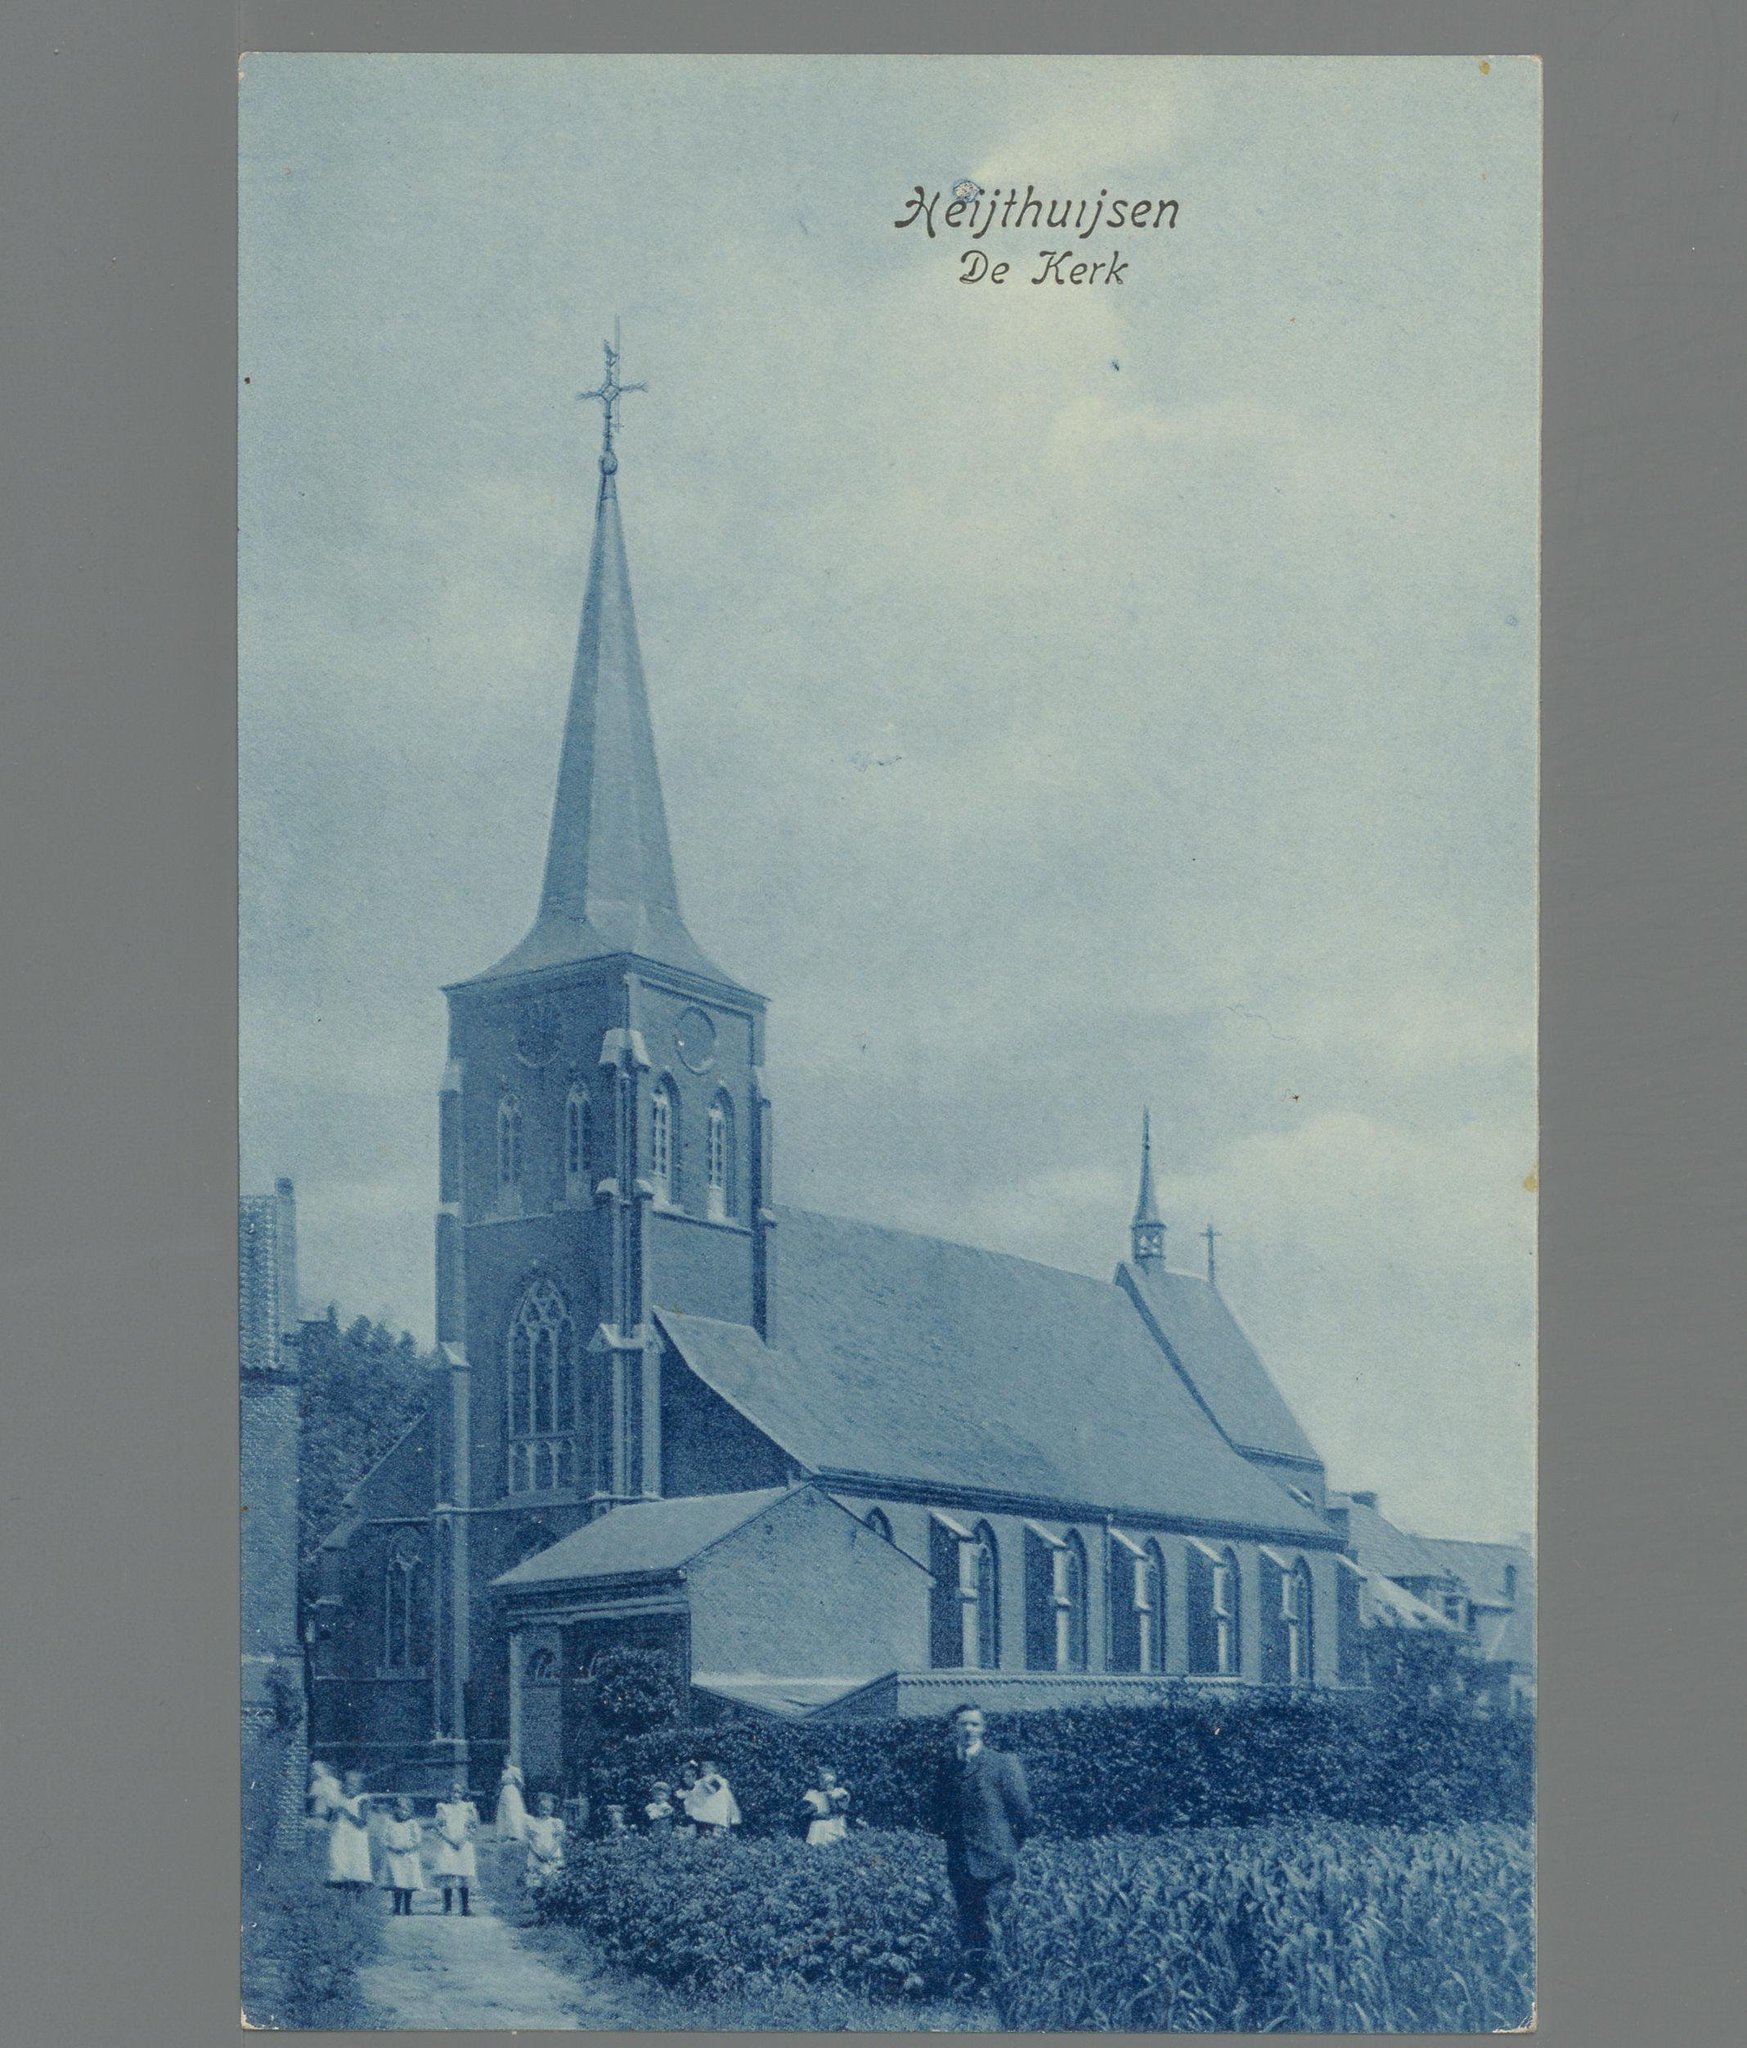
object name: ansichtkaart, prentbriefkaart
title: Heijthuijsen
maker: Anonymous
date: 1905-1930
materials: cardboard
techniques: photograph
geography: heythuysen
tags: church (exterior)